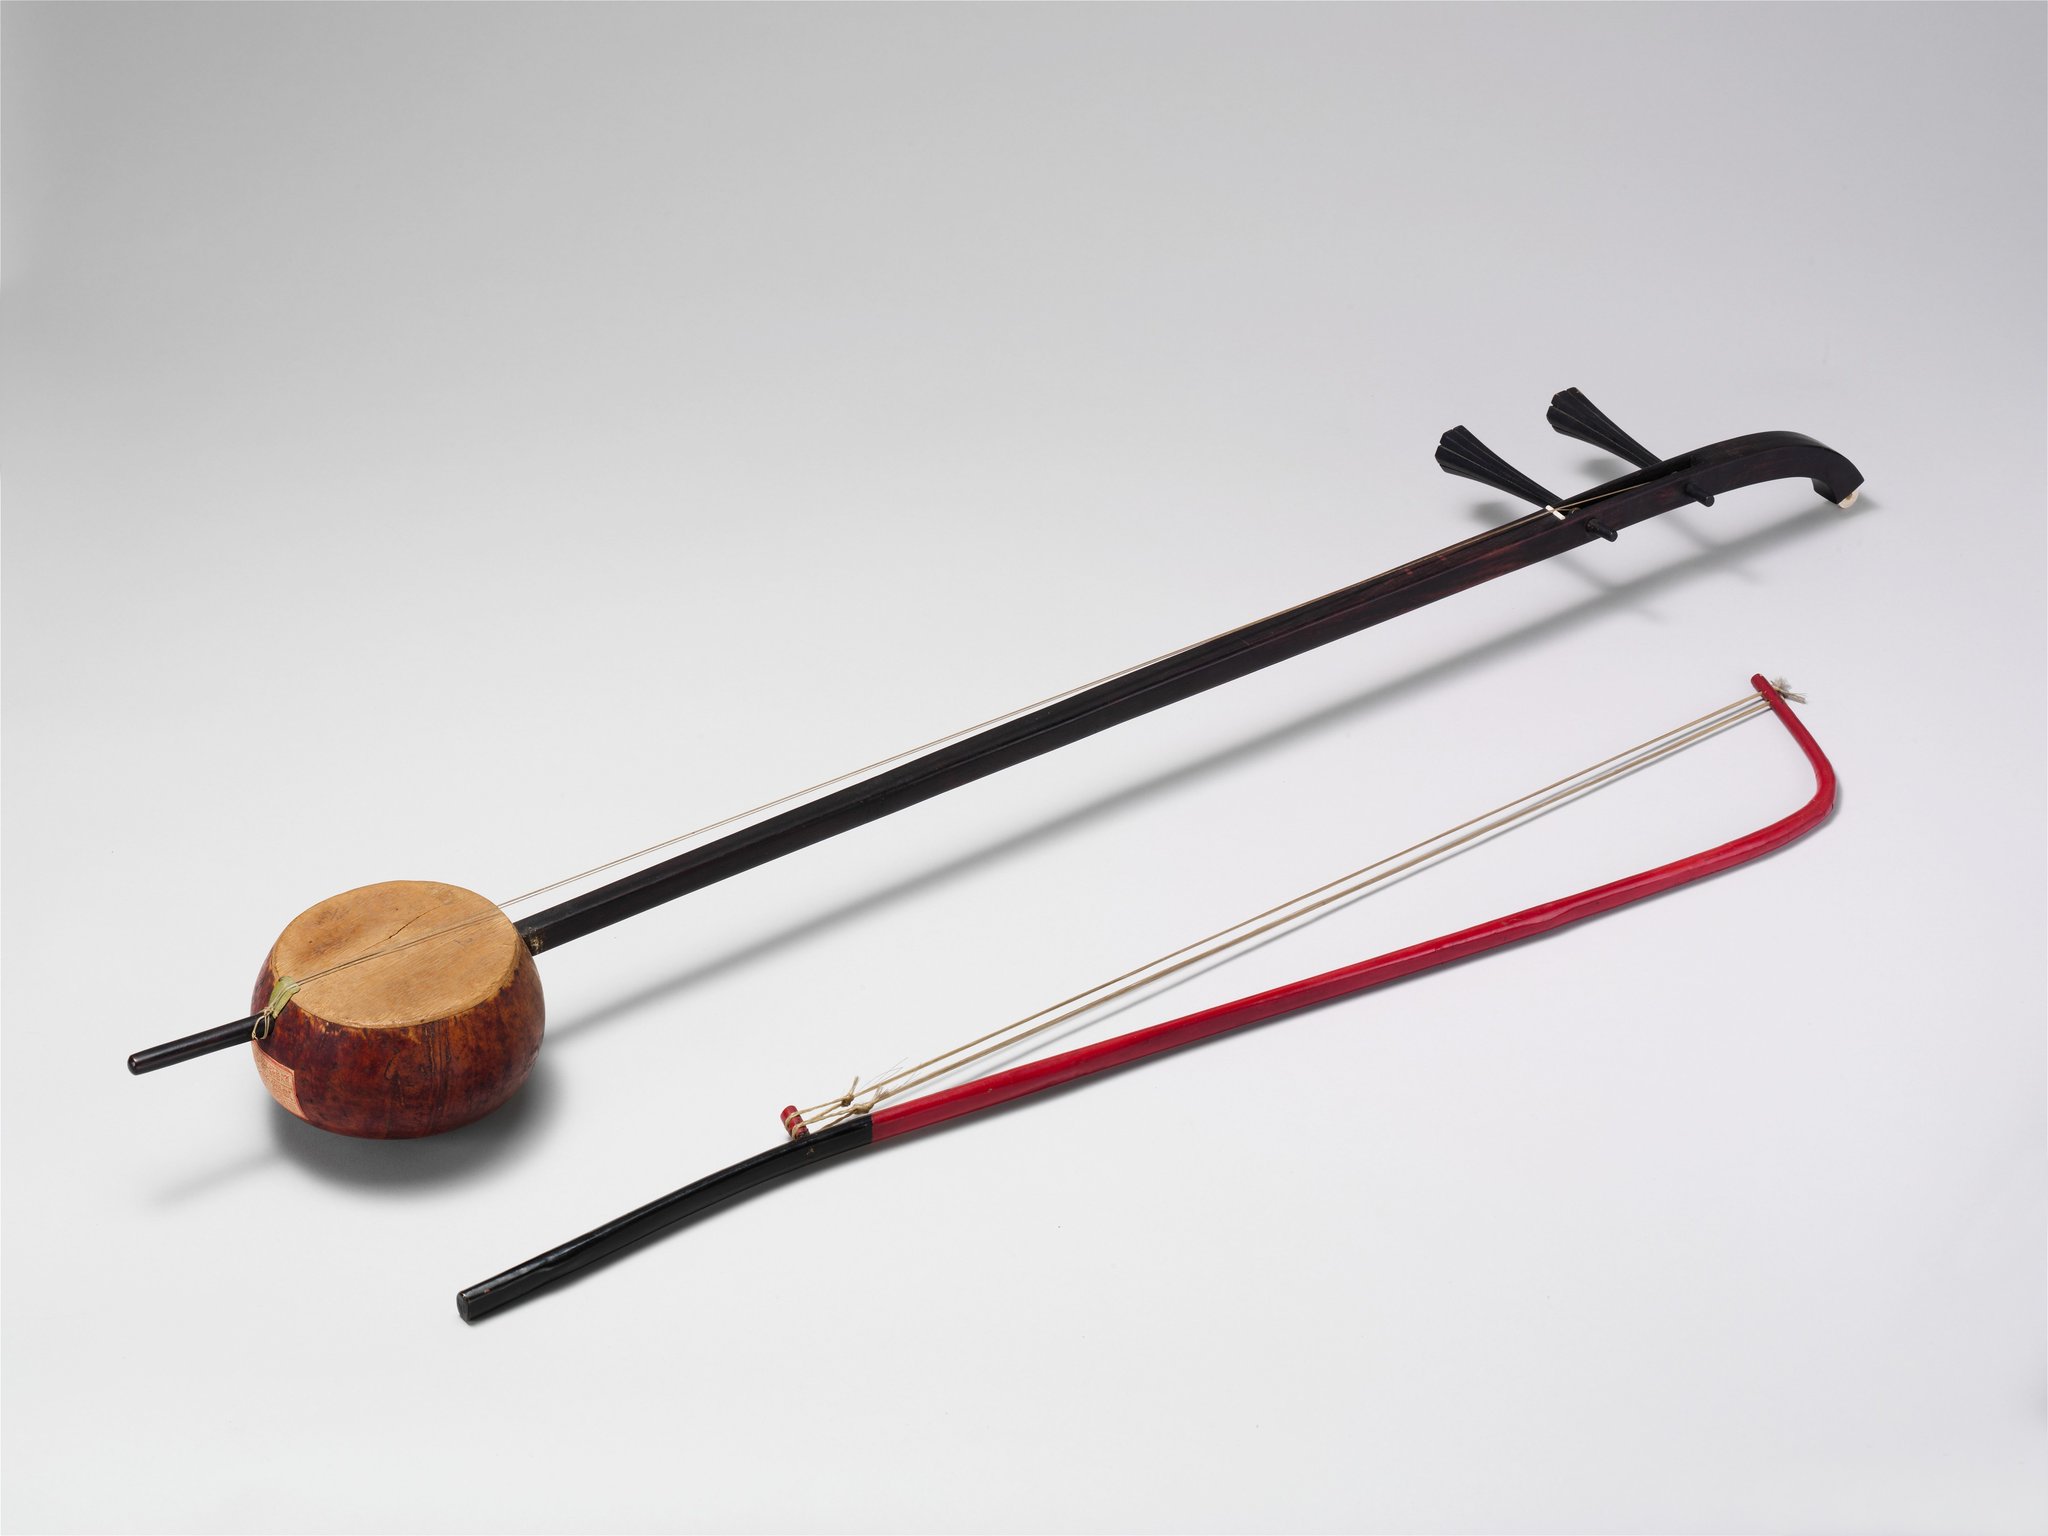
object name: tiqin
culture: chinese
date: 1801-1900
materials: wood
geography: china